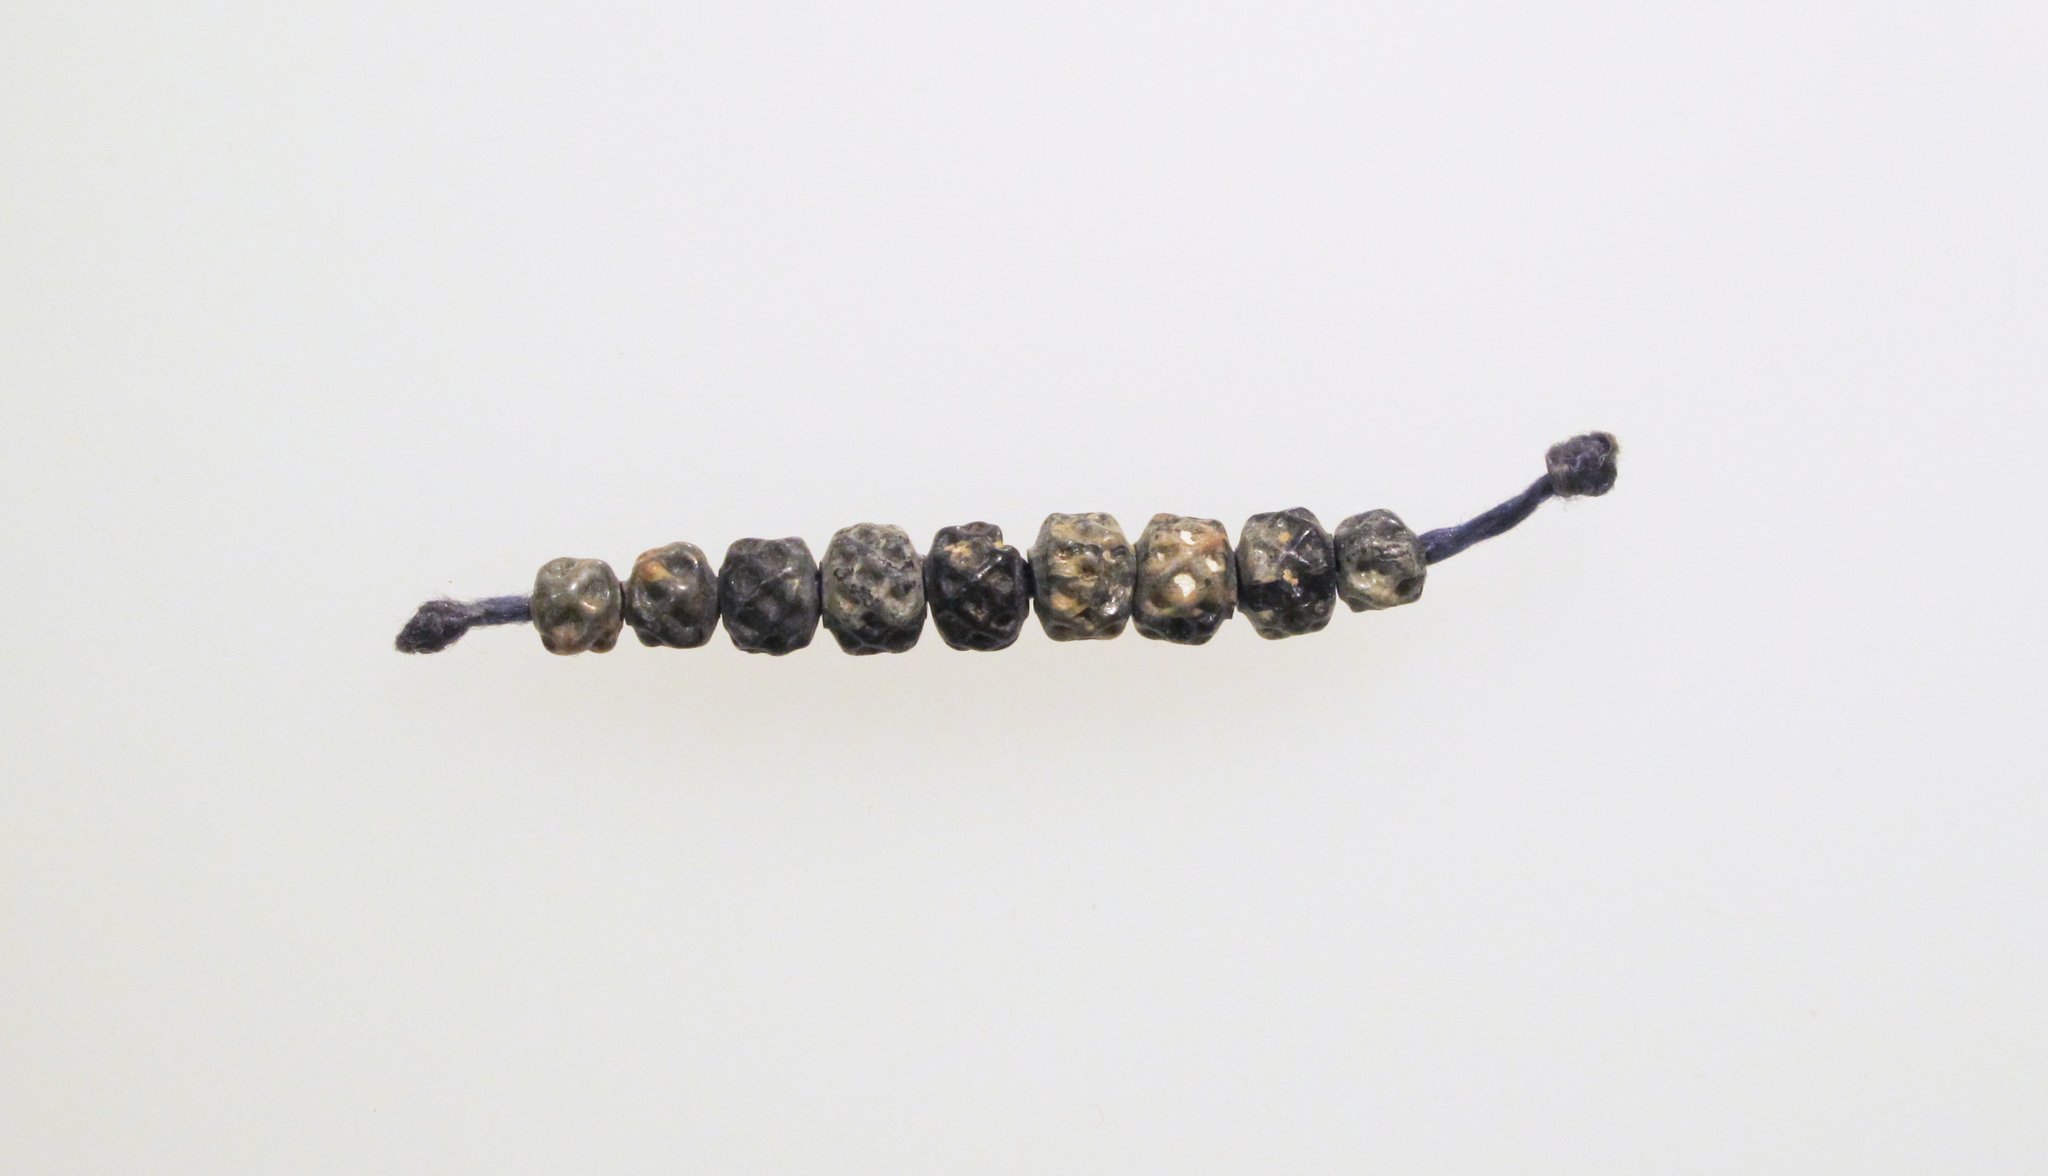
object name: bead, 9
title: Beads, 9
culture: roman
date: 670 BCE-330 CE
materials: glass